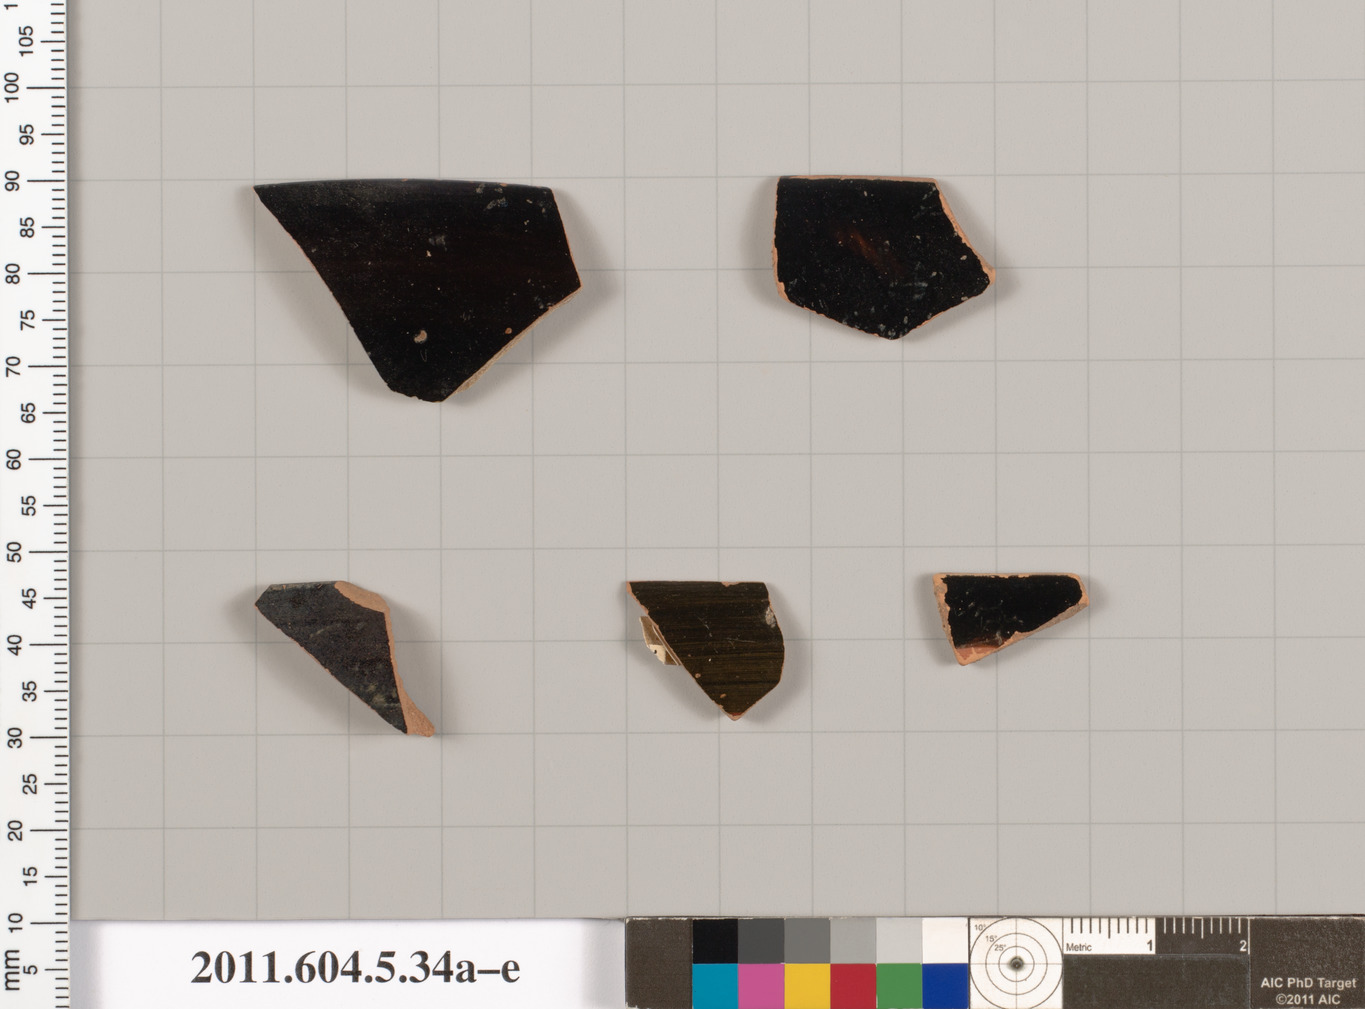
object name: kylix fragment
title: Terracotta rim fragments of kylikes (drinking cups)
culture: greek, attic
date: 467-435 BCE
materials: terracotta